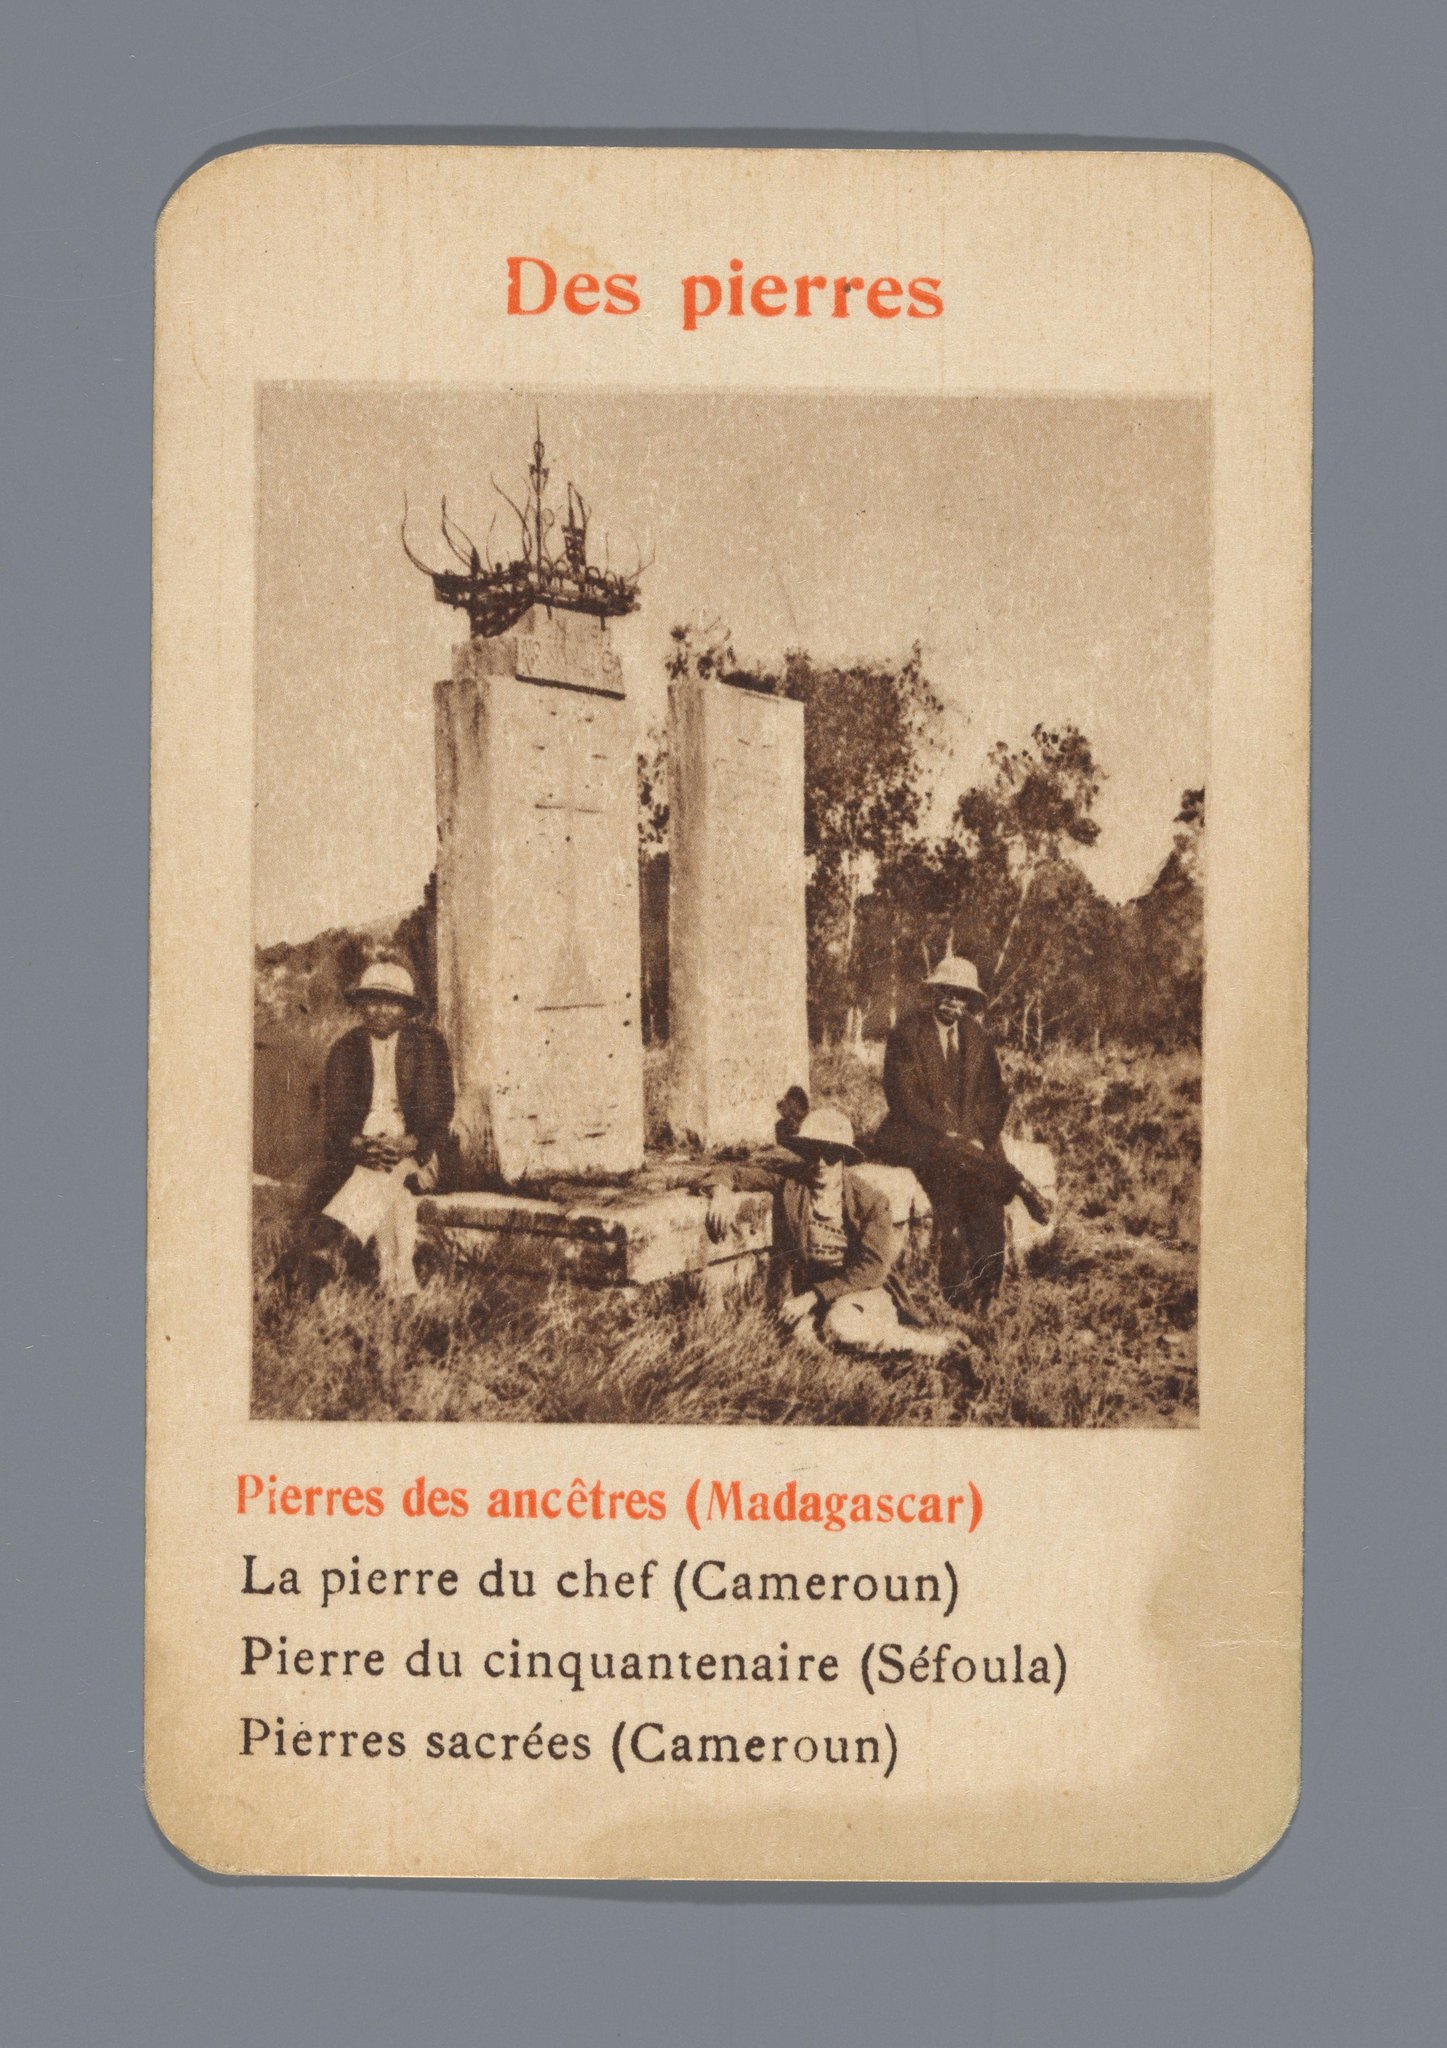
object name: photomechanical print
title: Des pierres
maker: Anonymous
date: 1900-1920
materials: cardboard, paper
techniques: rotogravure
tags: african traditional religions, card games